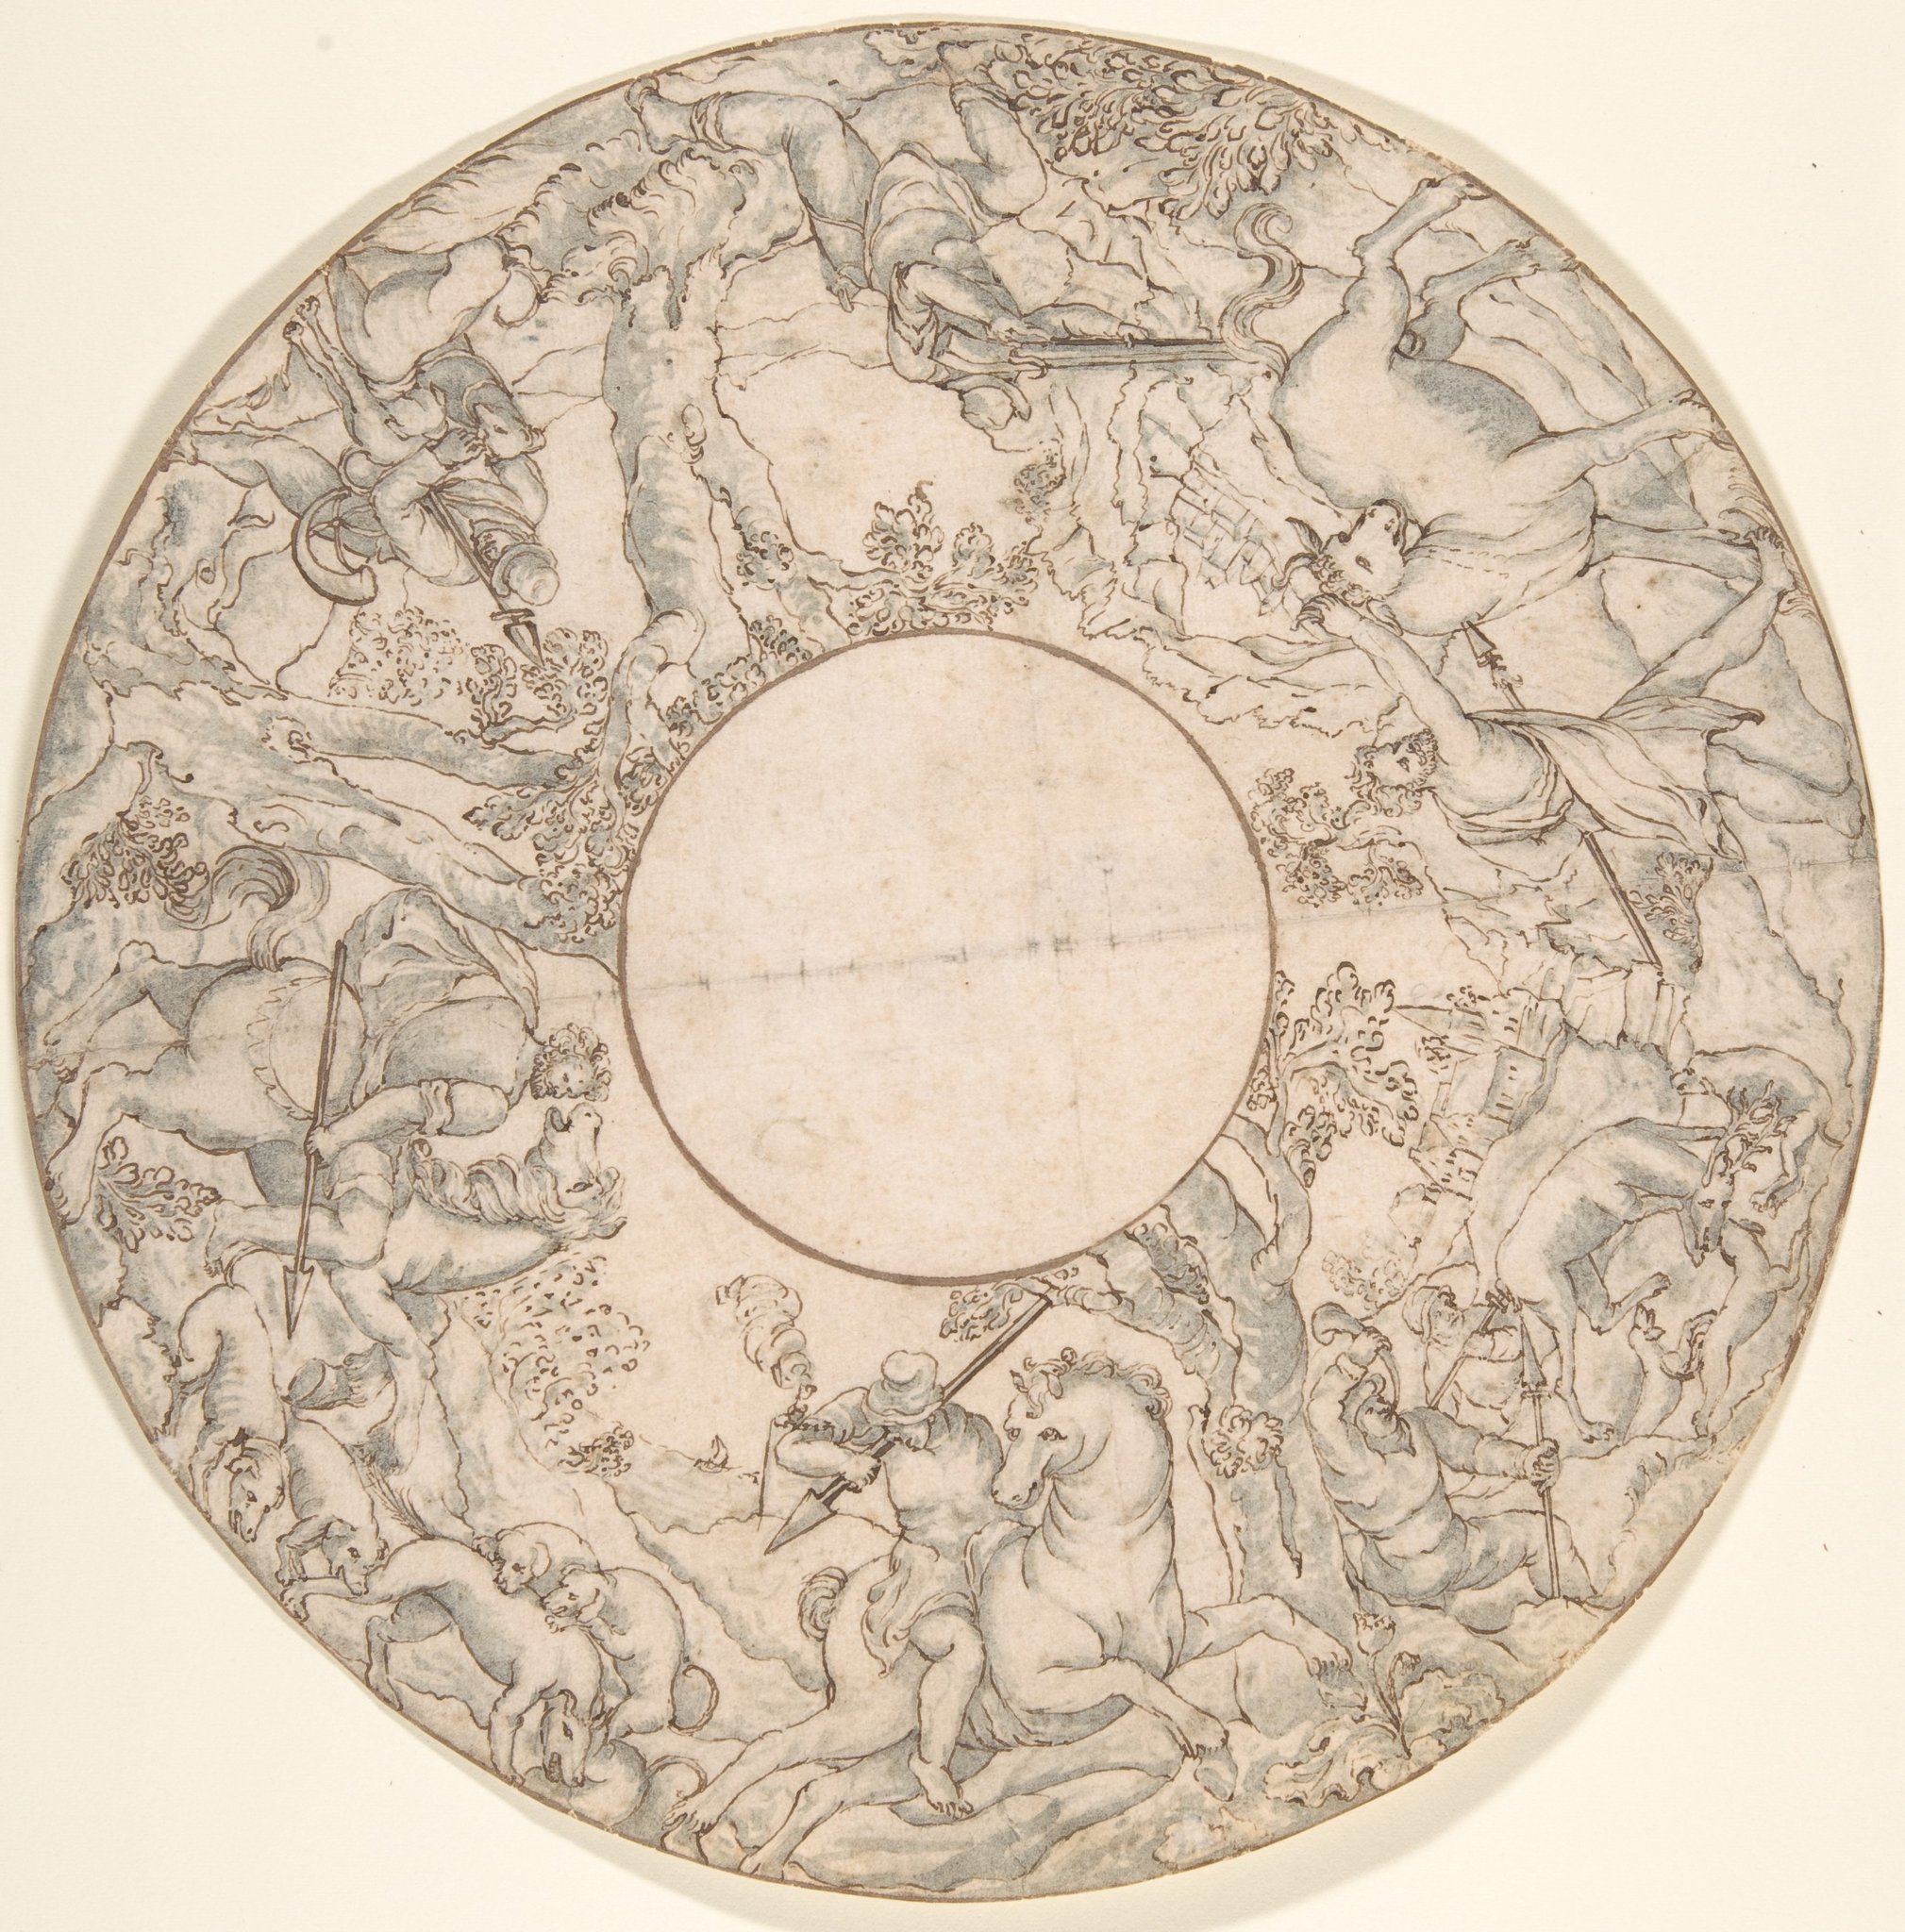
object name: drawing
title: Hunting Scene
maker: anonymous, netherlandish, 16th century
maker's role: artist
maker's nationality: netherlandish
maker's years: 1500-1600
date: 1501-1600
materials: ink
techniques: brush, incising, pen, wash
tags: men,hunting,horses